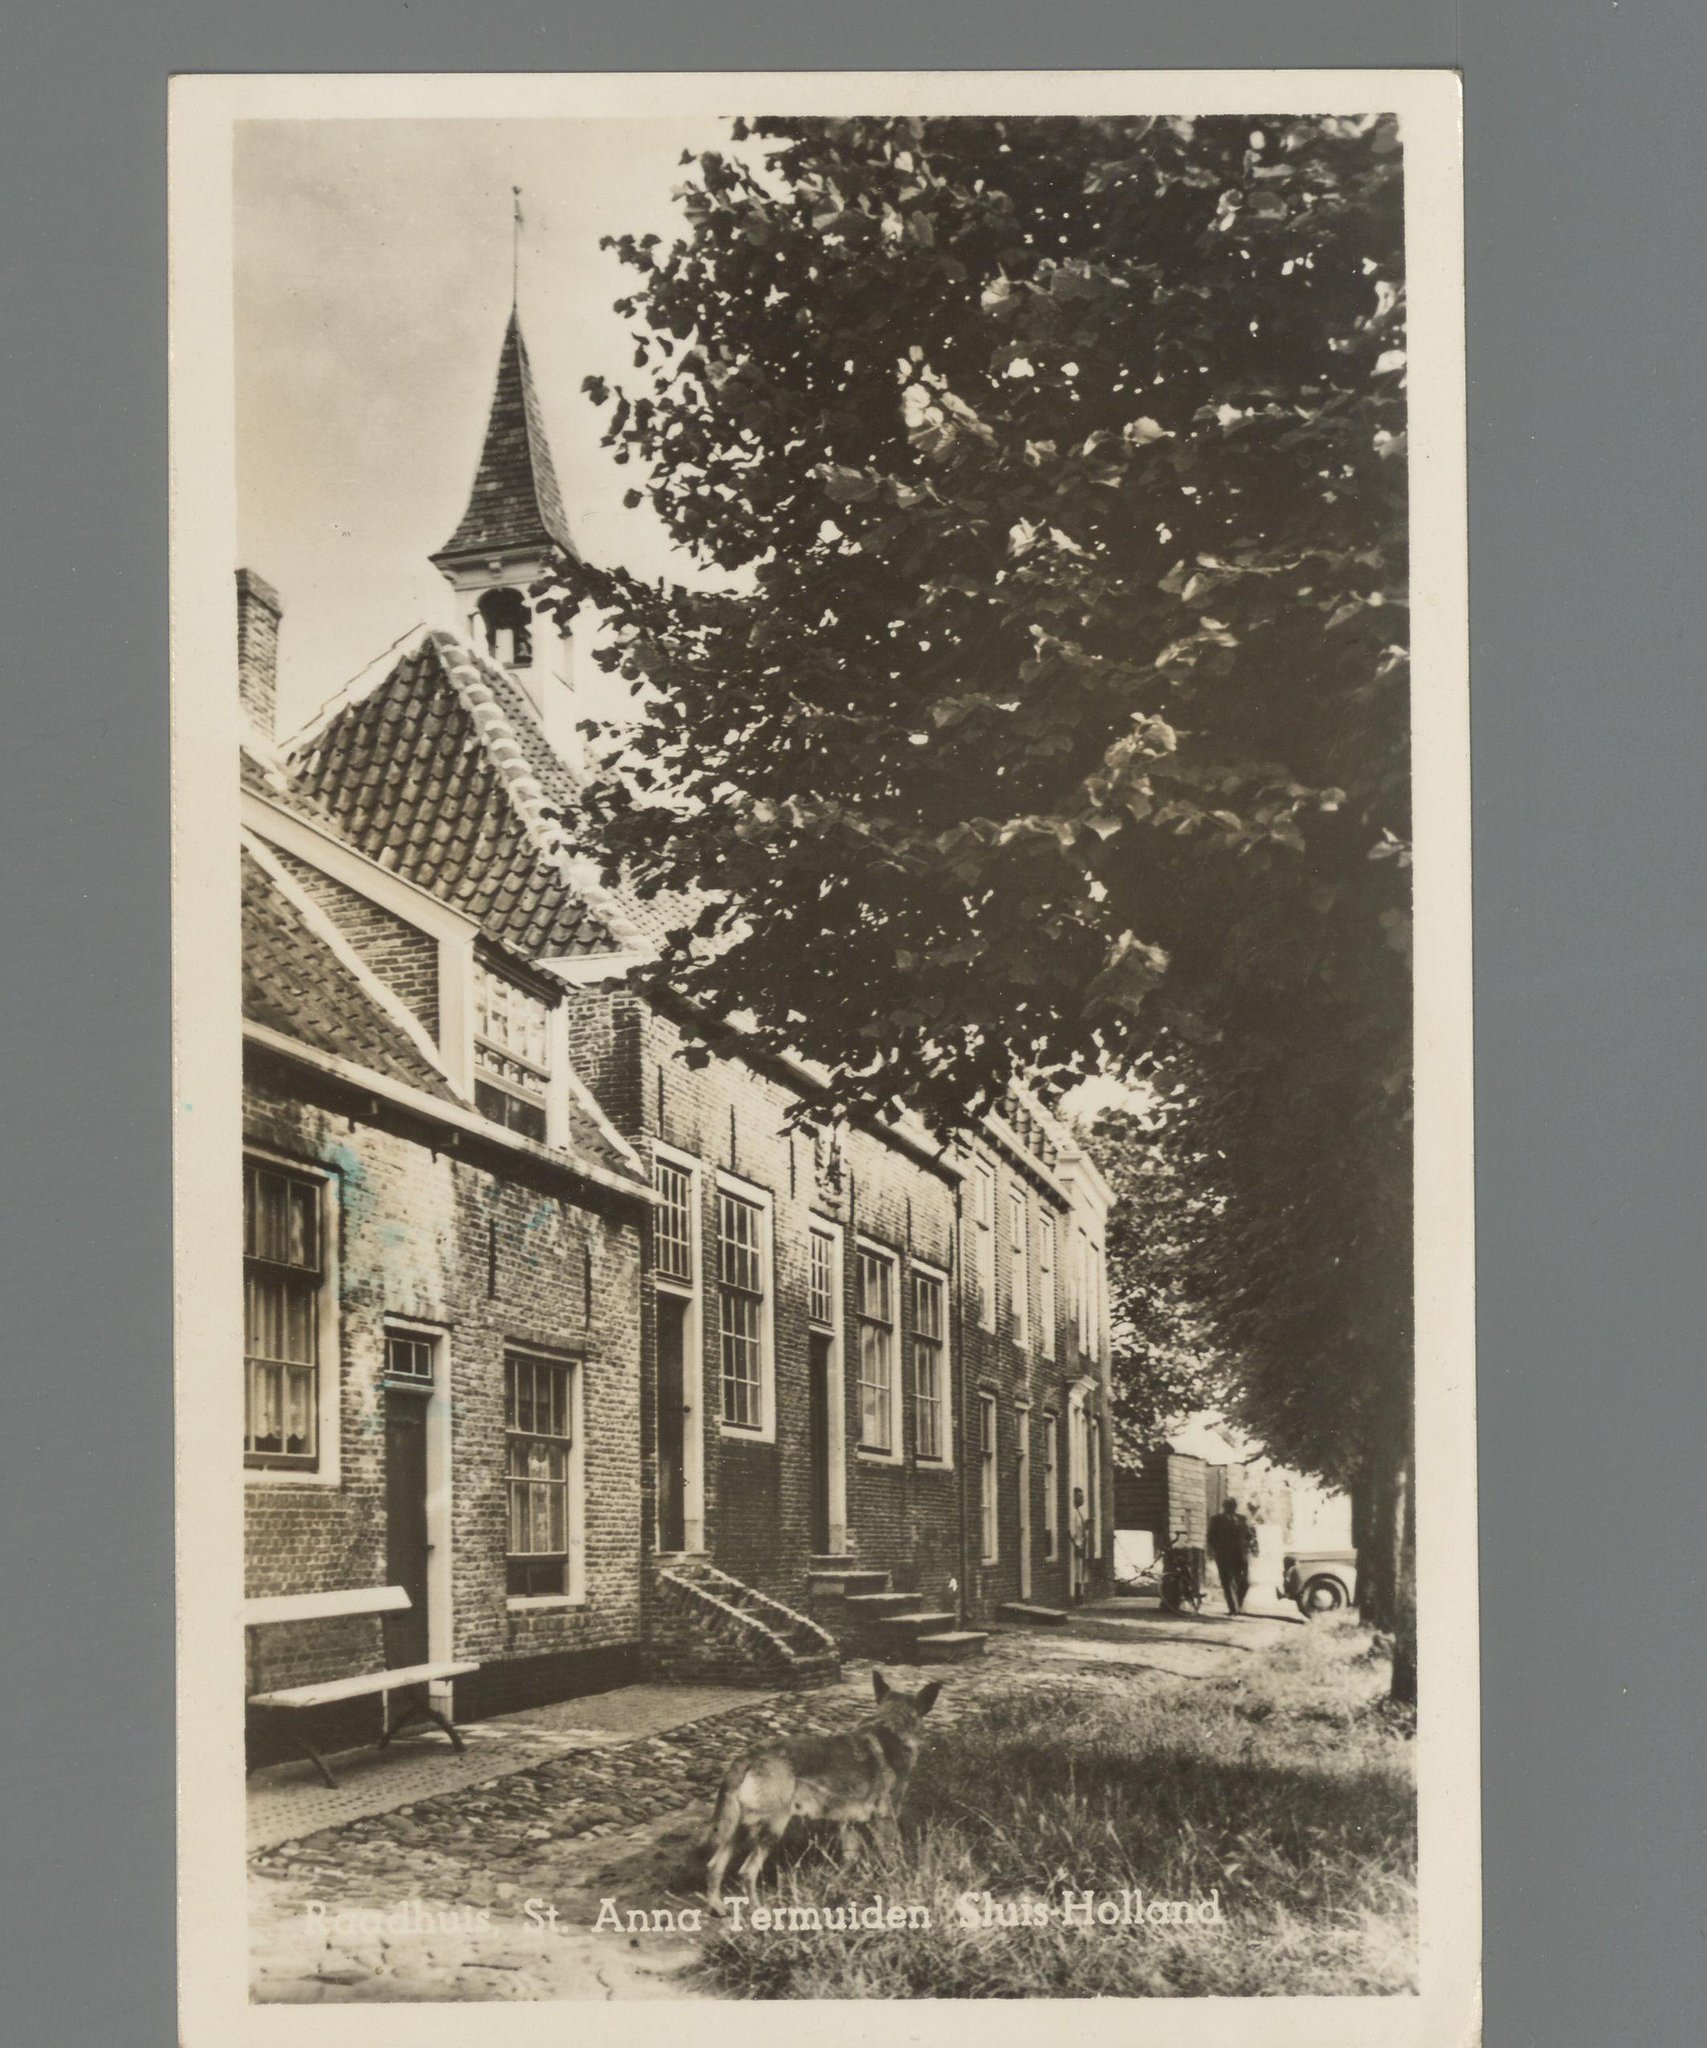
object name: ansichtkaart, prentbriefkaart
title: Raadhuis, St. Anna Termuiden. Sluis-Holland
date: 1929-1952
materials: paper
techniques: gelatin silver print, writing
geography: middelburg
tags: townhall, street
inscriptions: postage stamp